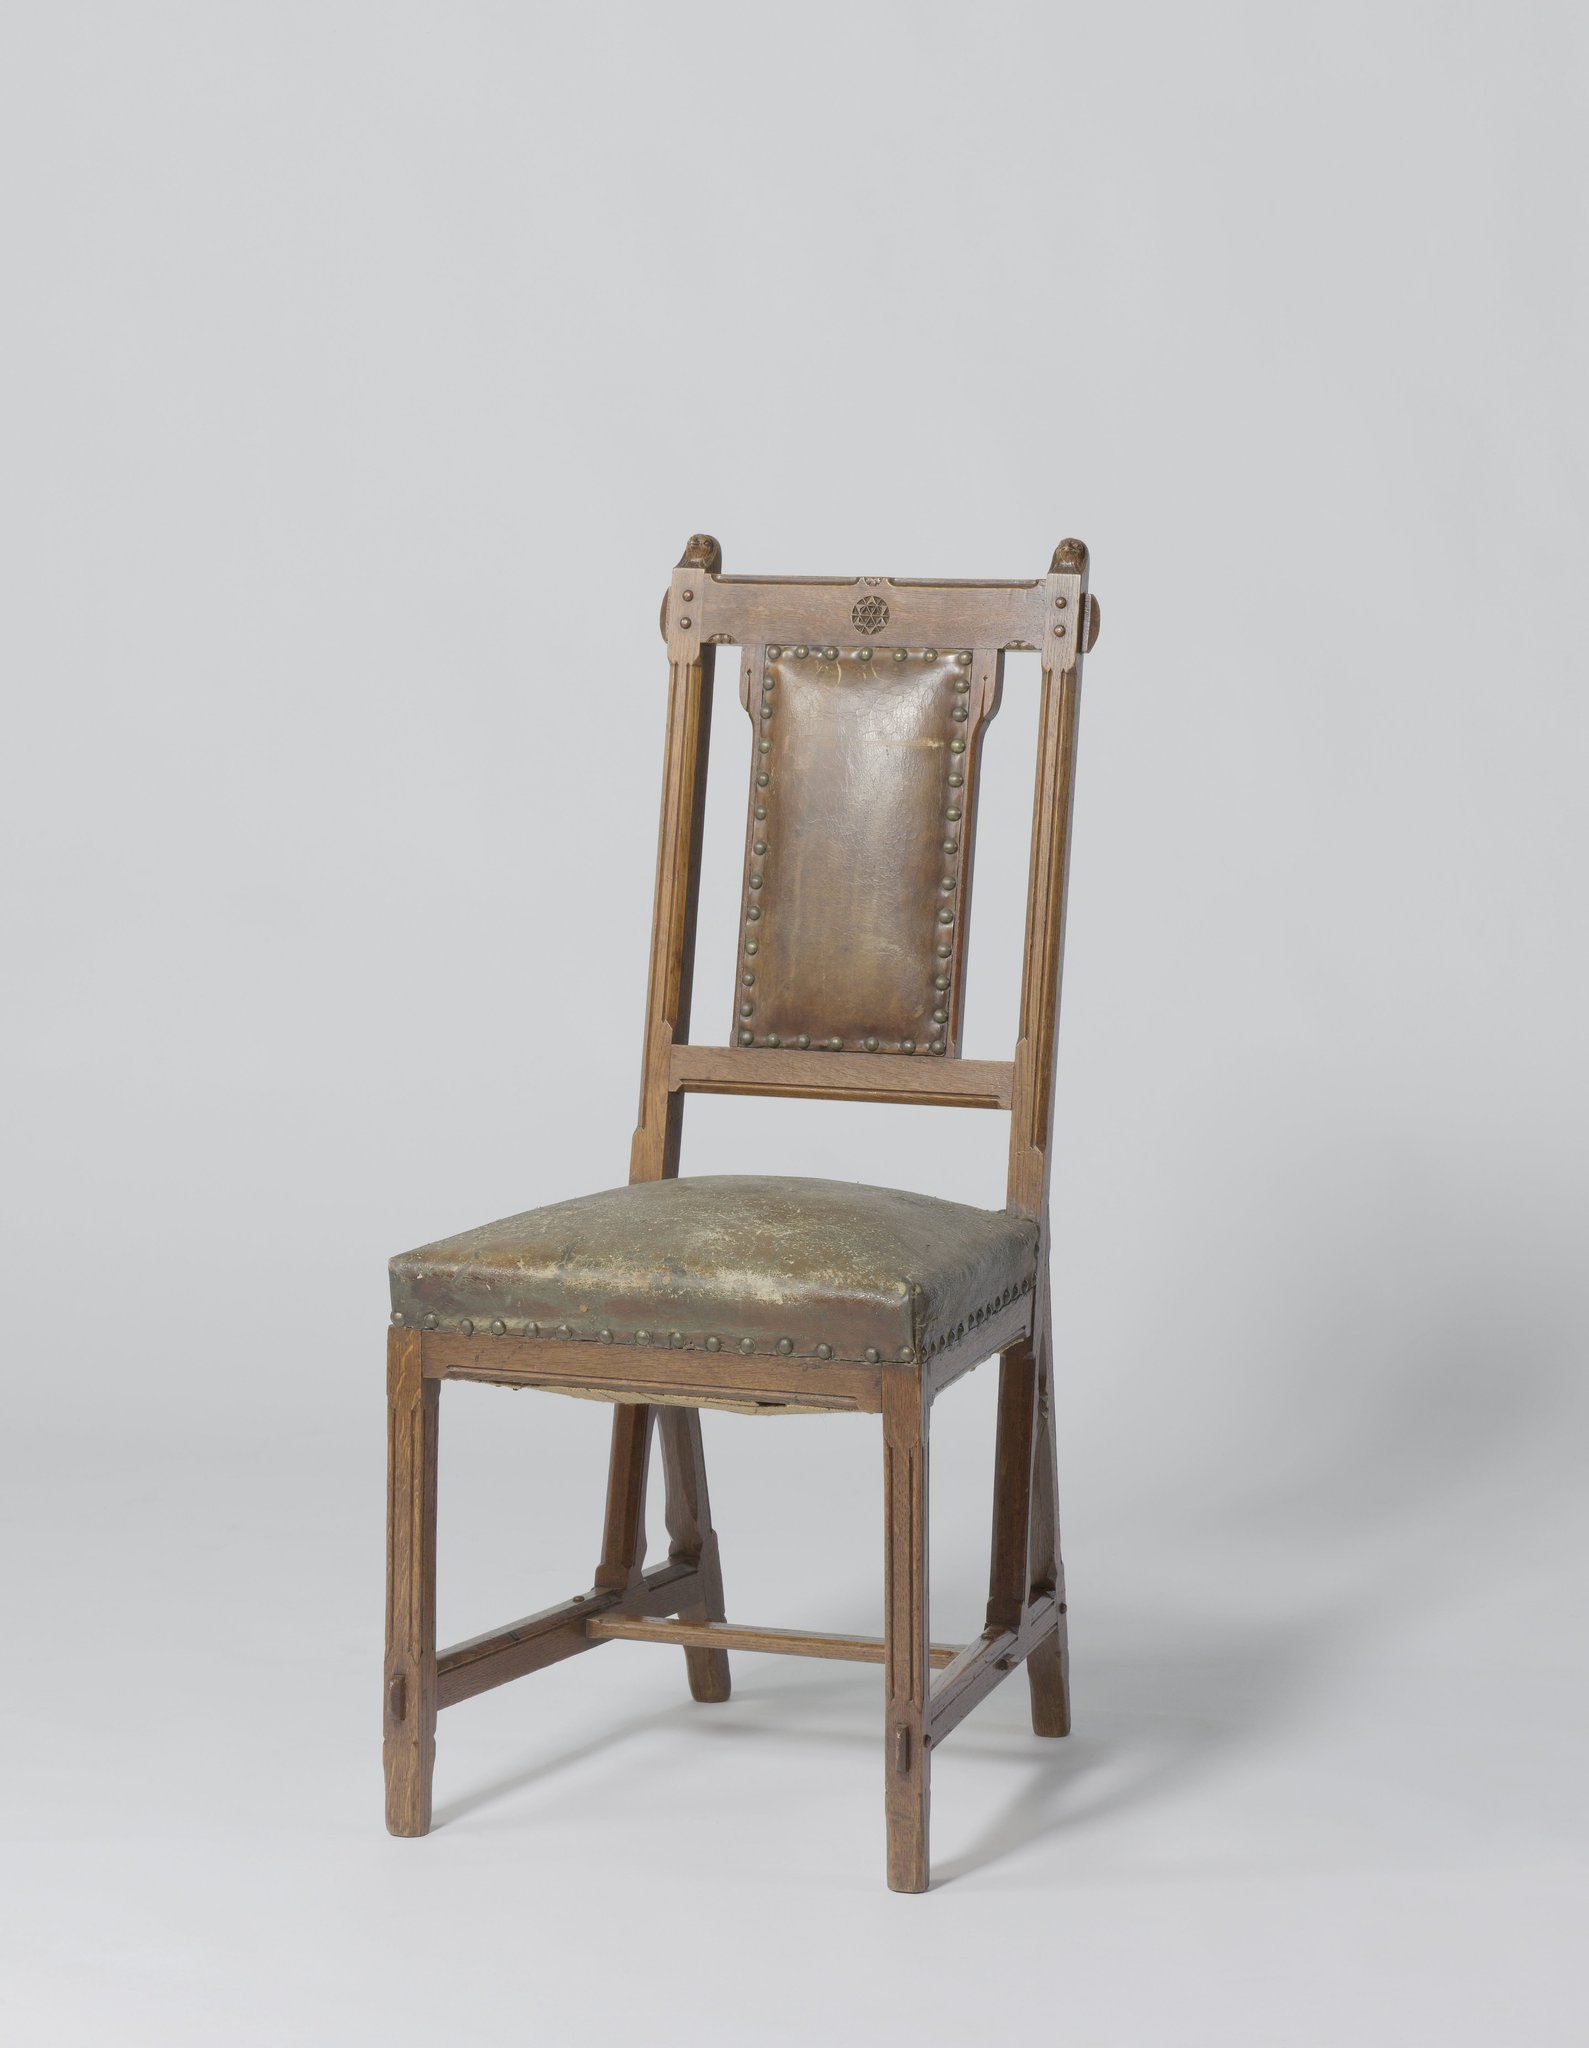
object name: seating furniture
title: Stoel met een bruin lederen bekleding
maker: hendrik petrus berlage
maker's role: draughtsman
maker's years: 1856-1934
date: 1902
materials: leather, wood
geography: amsterdam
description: Sideboard and two dining chairs. Oak. Amsterdam, J.B. Hillen, 1902, designed by Hendrik Petrus Berlage. Made for the First International.